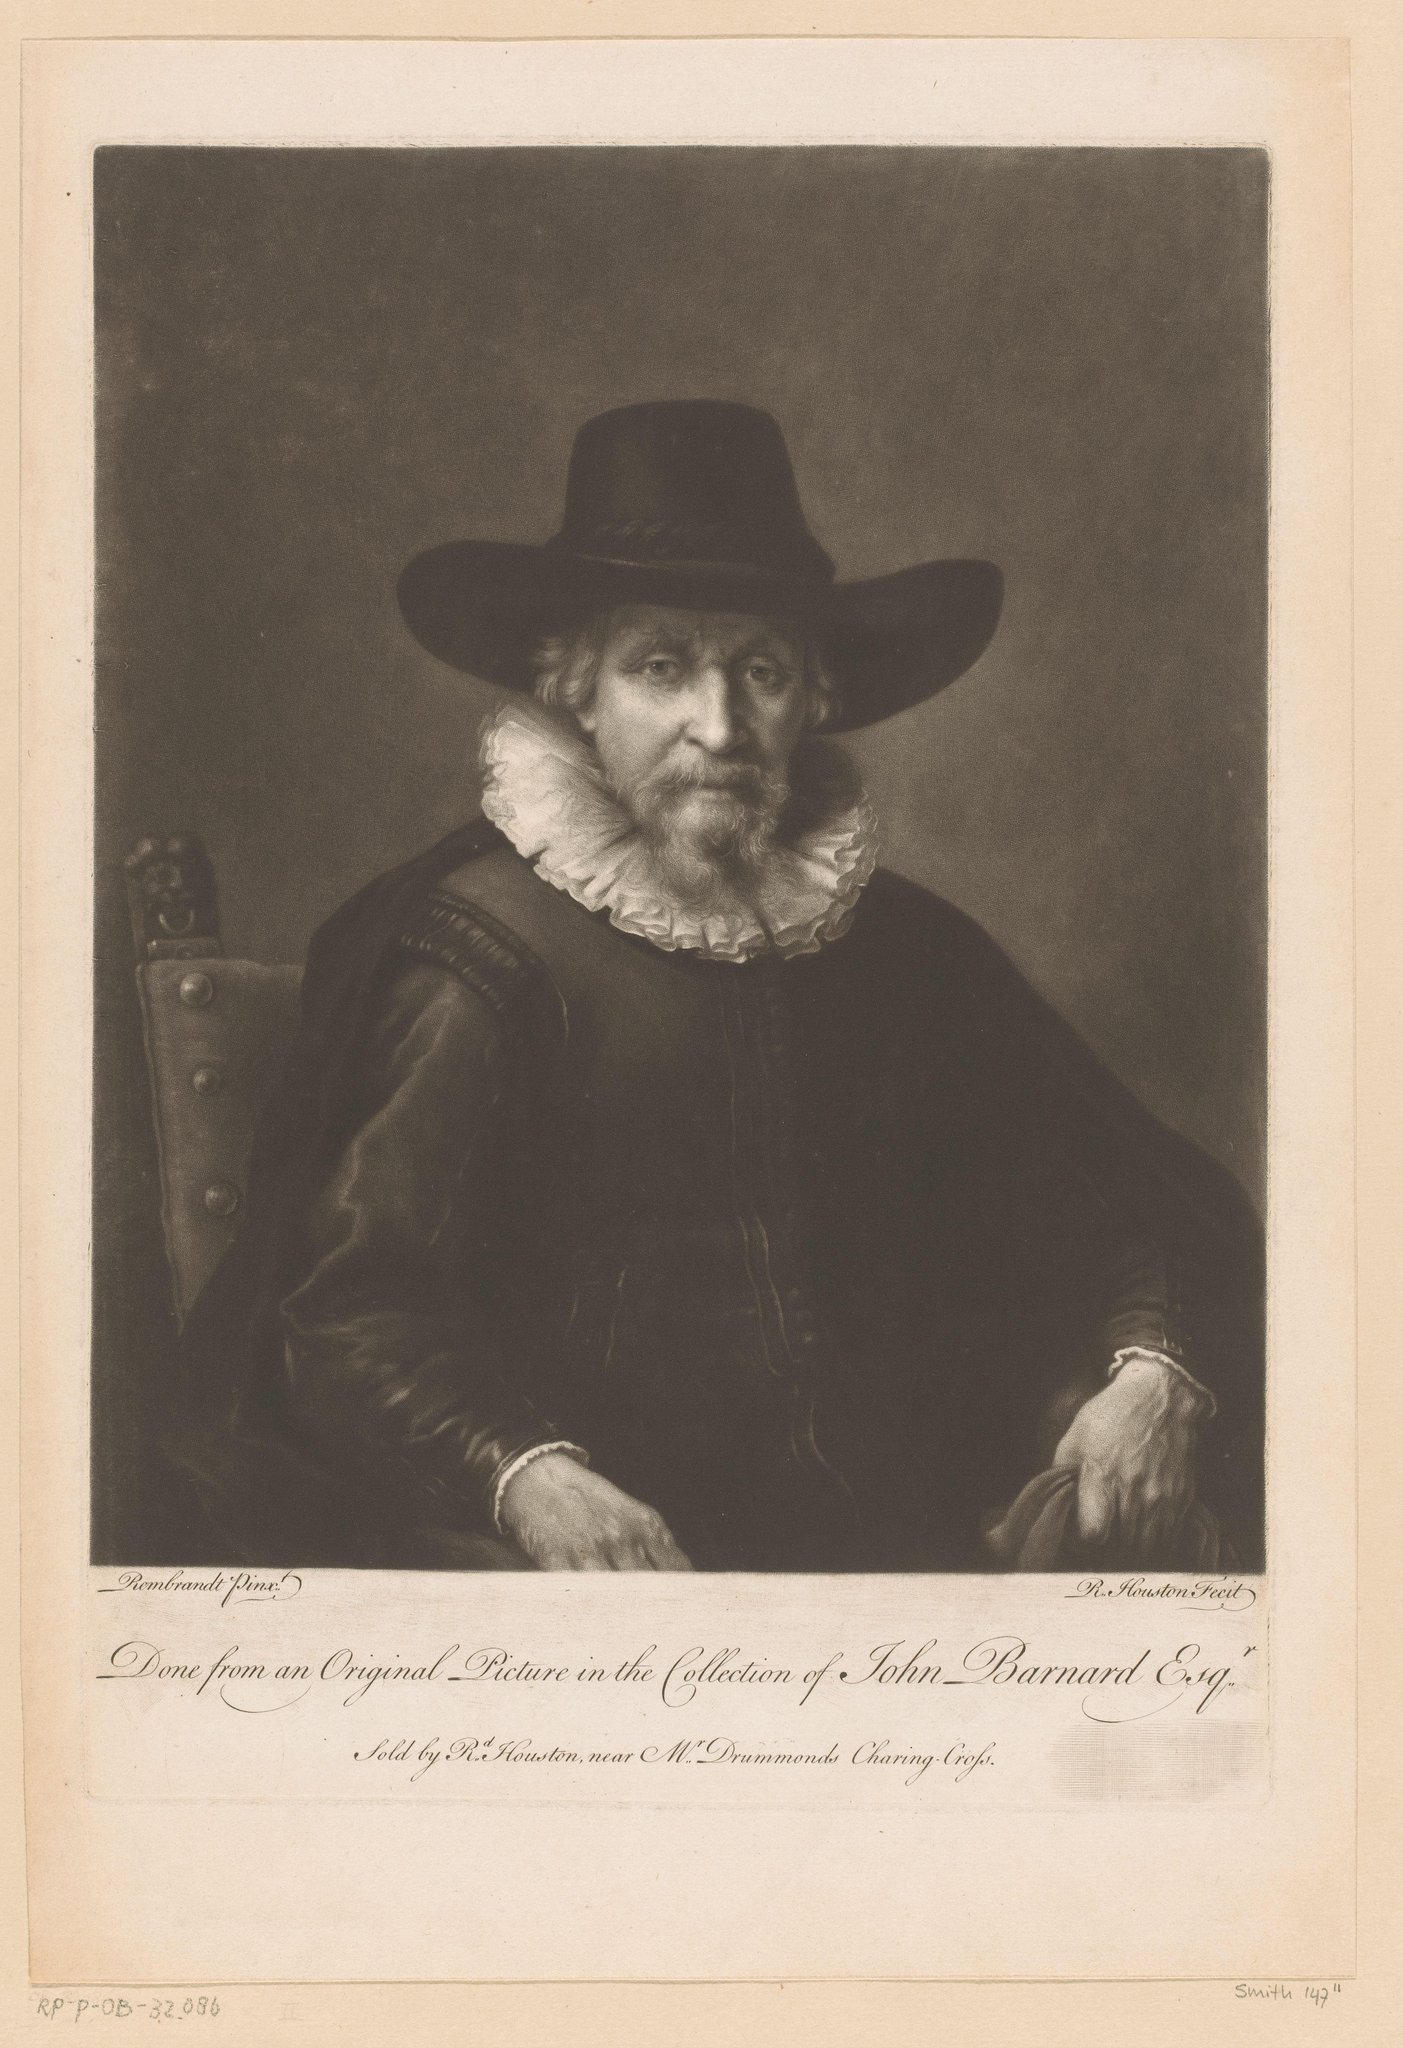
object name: print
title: Portret van een burgemeester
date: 1731-1775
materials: paper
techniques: mezzotint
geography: london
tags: mayor, burgomaster, historical persons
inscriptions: collector's mark: Lugt 240